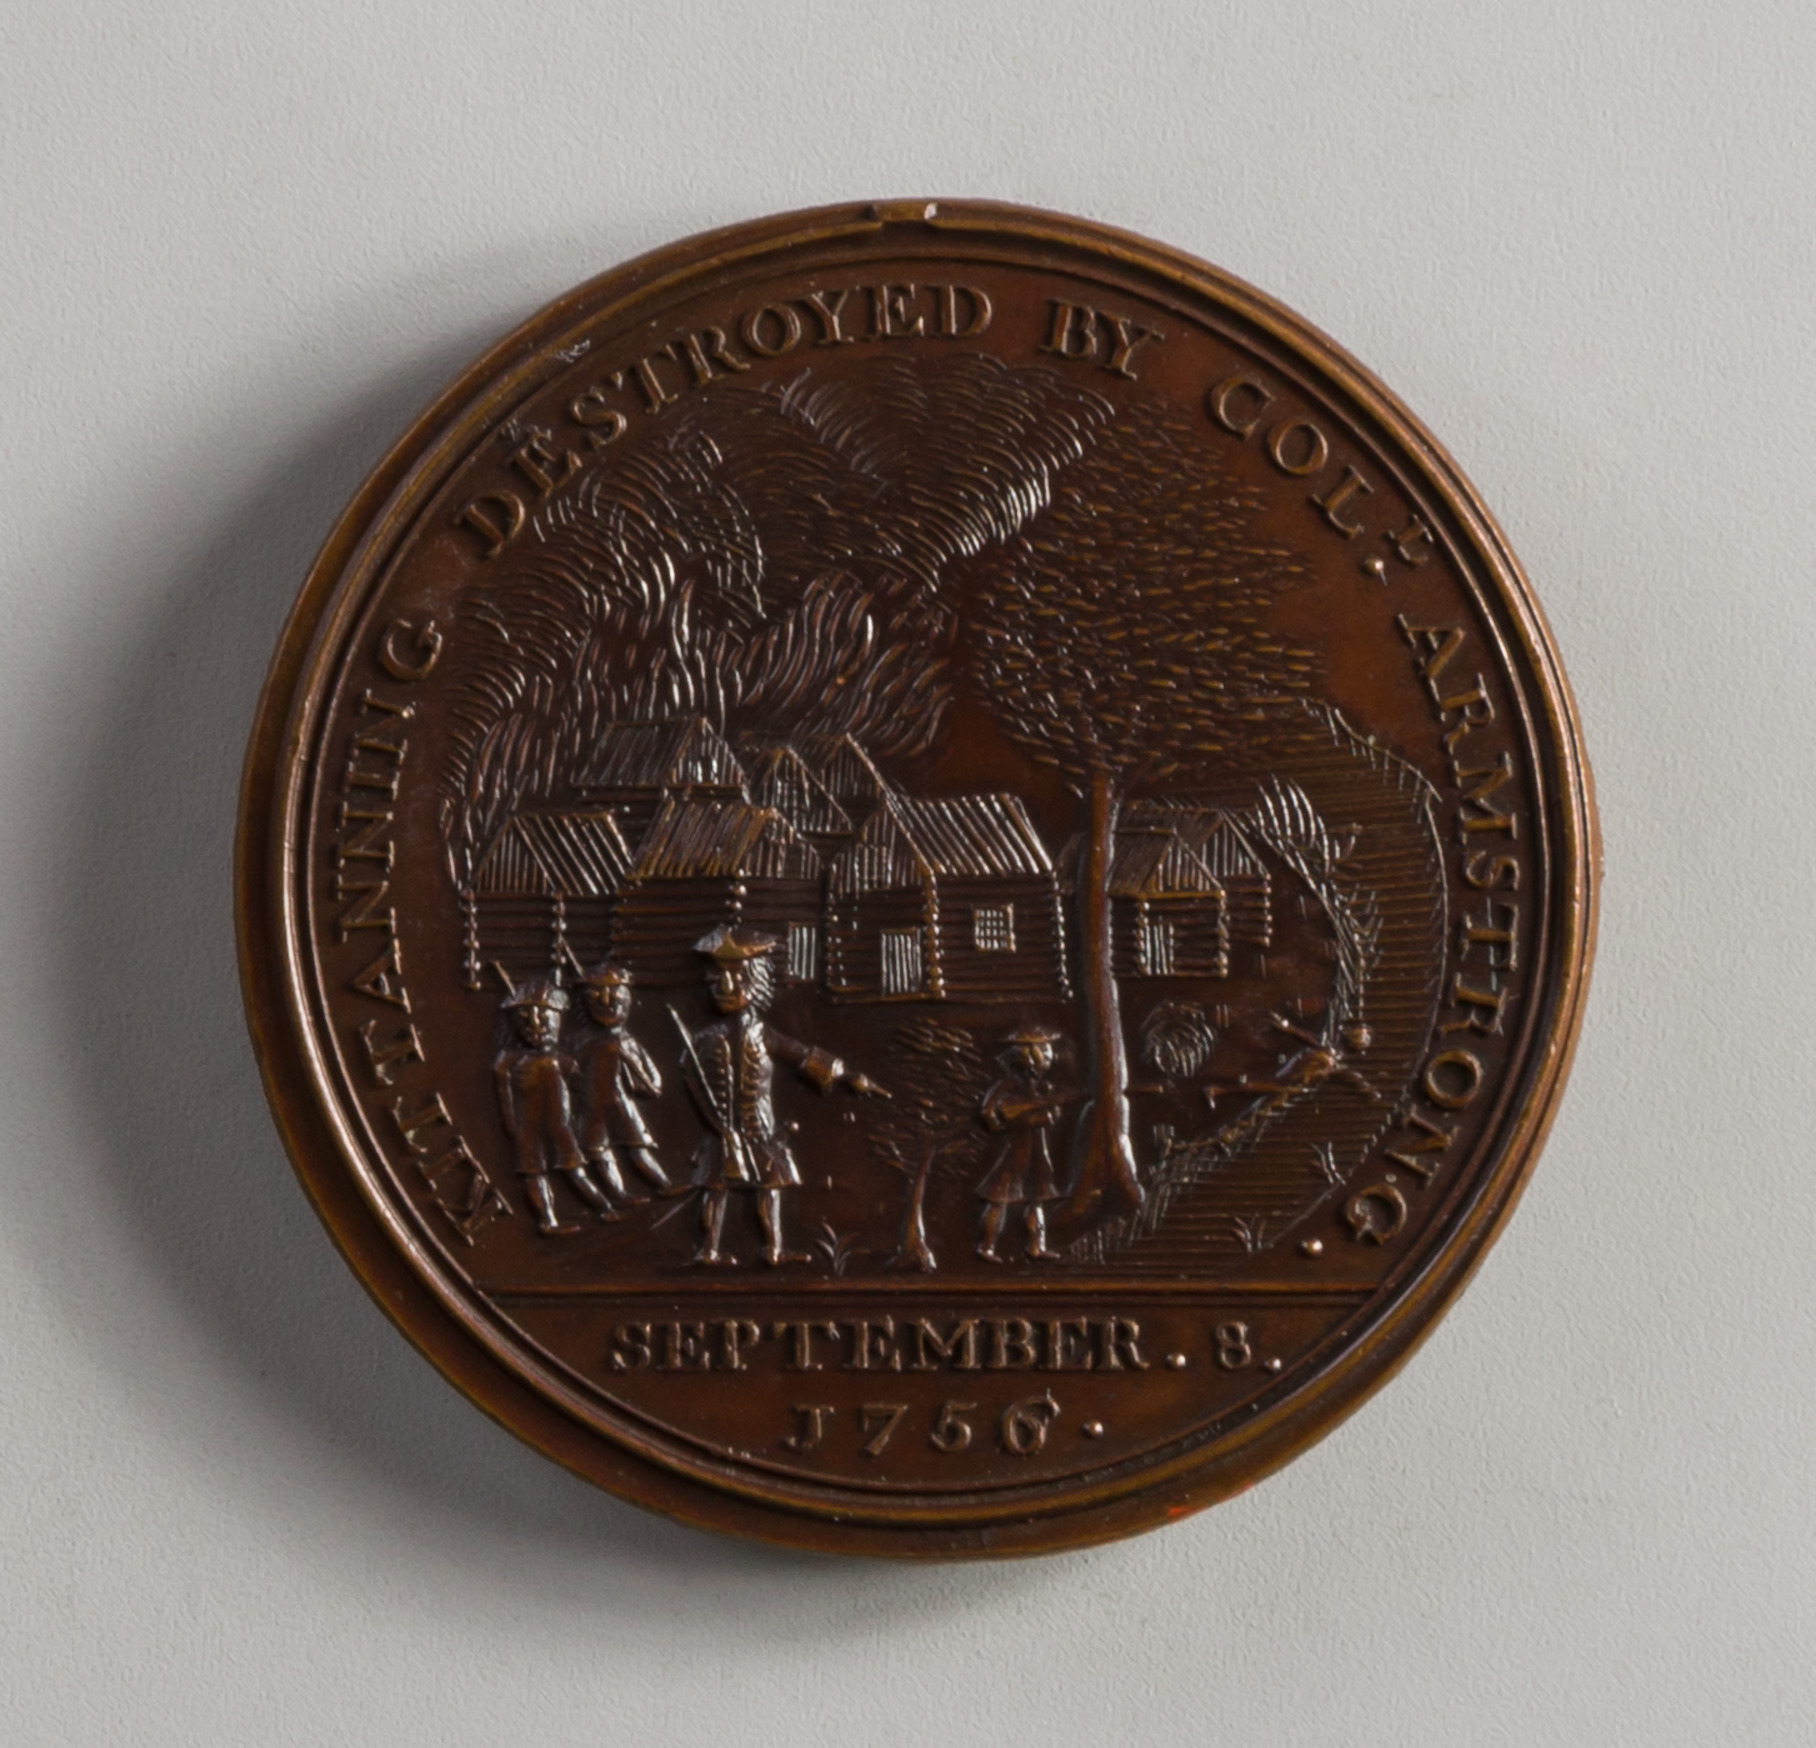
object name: medal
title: Medal of the Indian Village of Kittanning, Pennsylvania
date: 1756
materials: bronze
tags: men,coat of arms